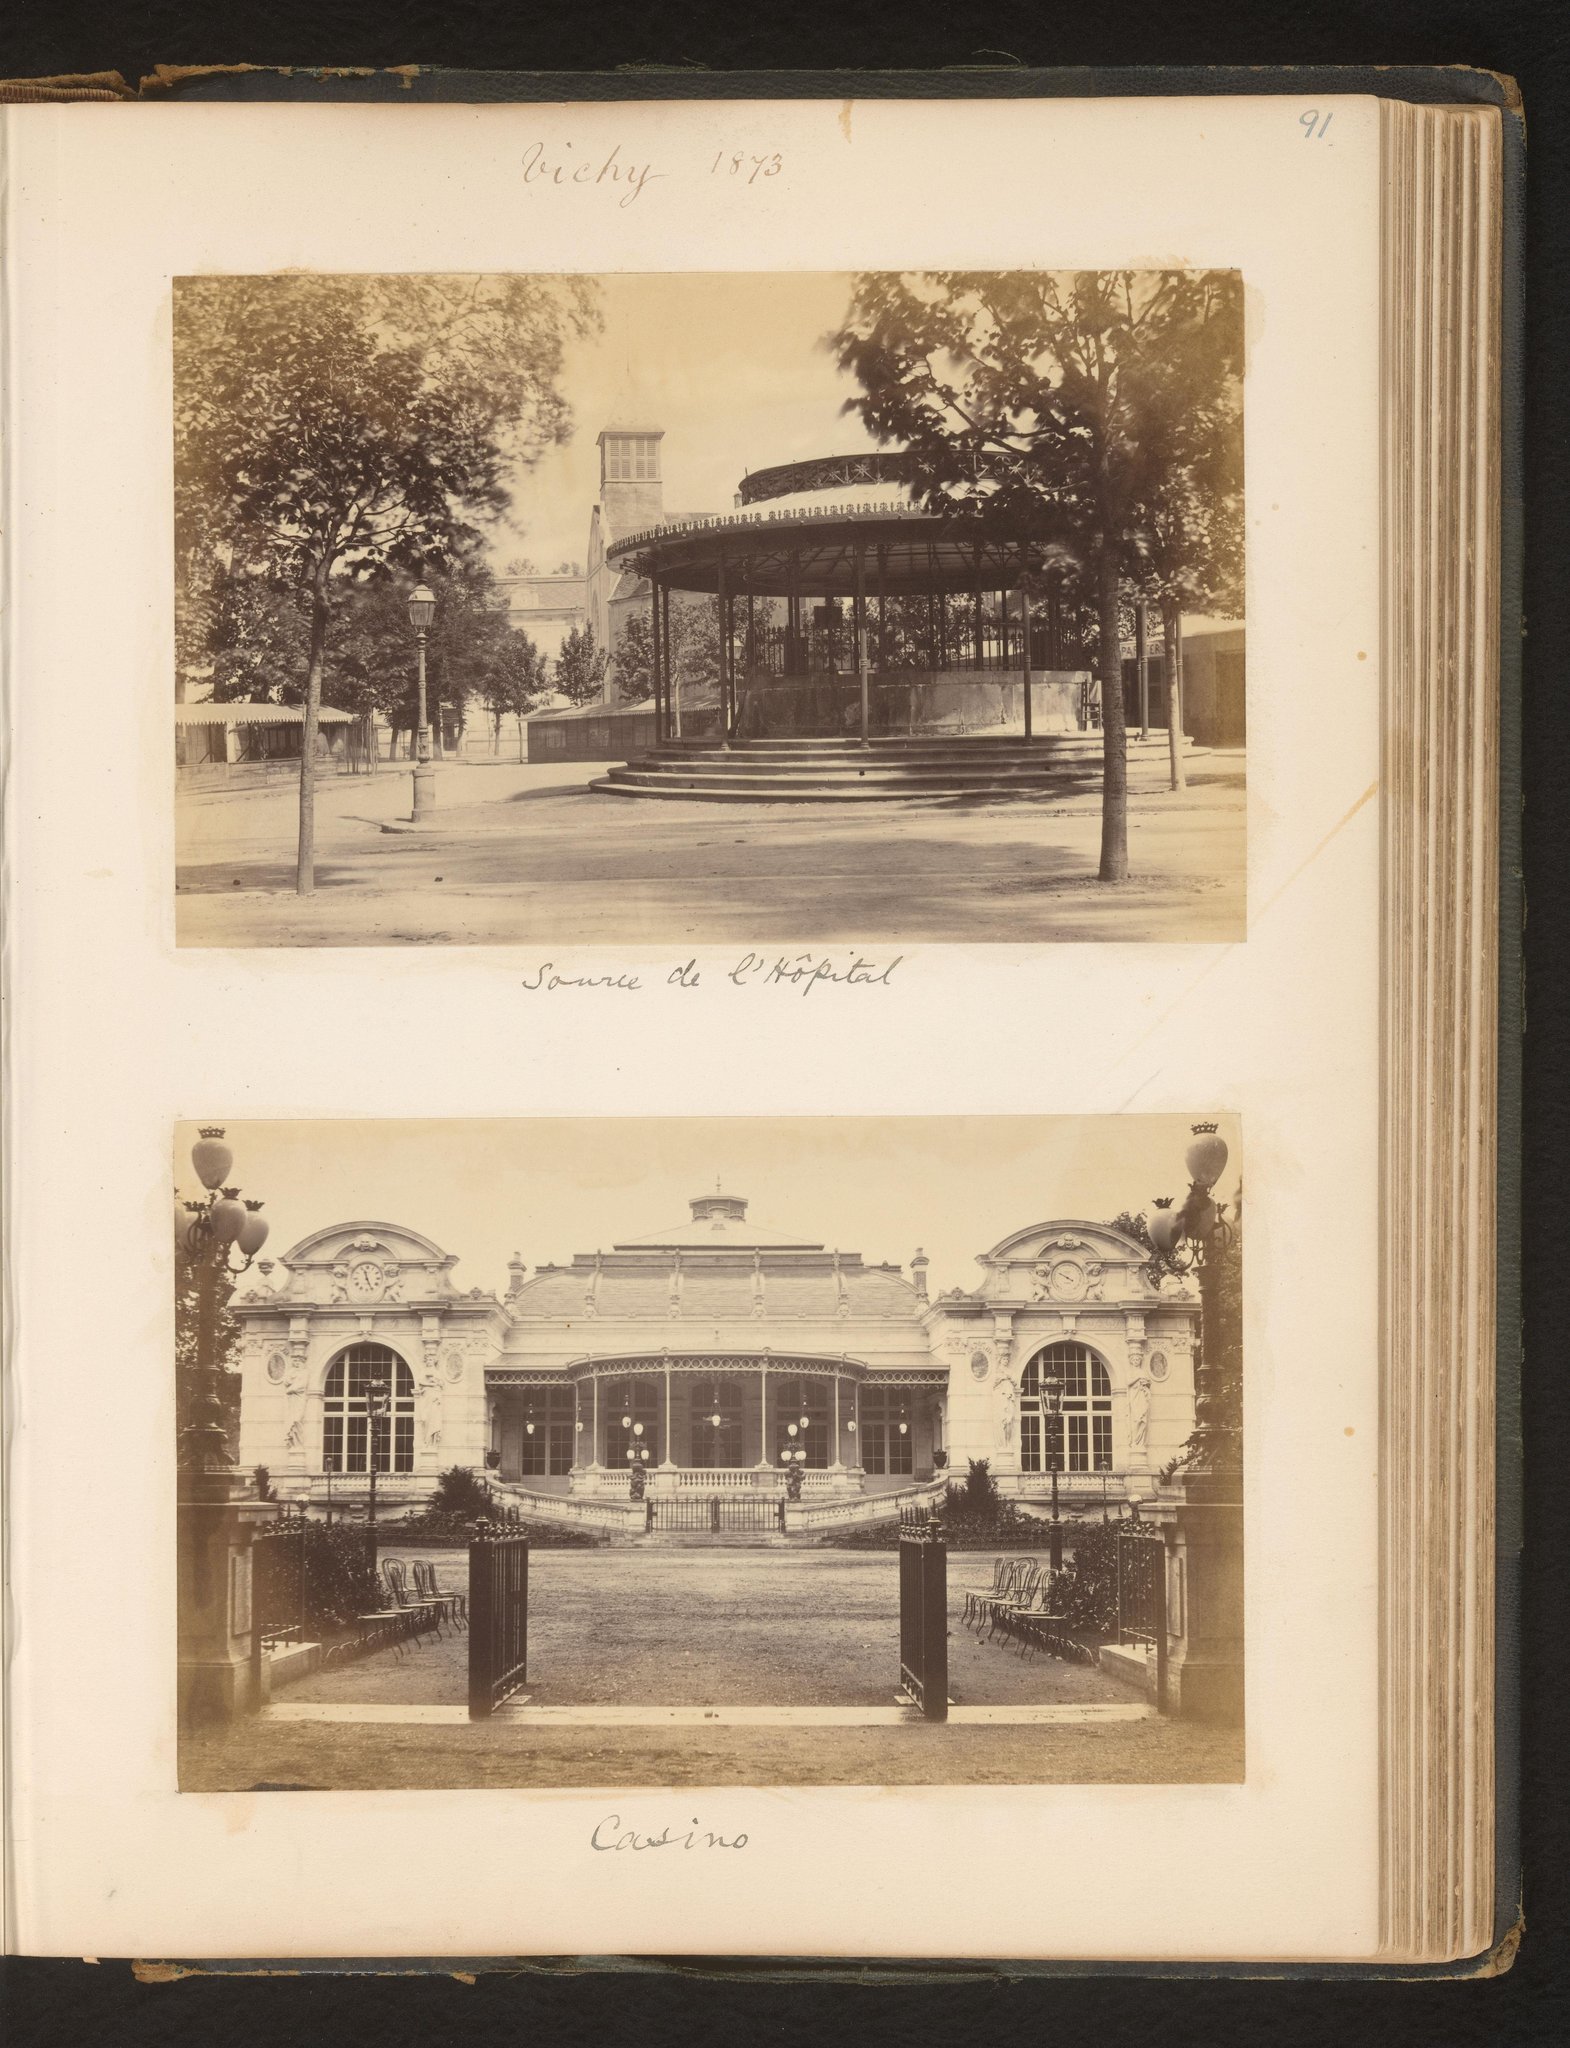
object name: album leaf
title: Gebouwen in Vichy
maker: Anonymous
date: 1873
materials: paper, photographic support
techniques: albumen print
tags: medicinal spring, casino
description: Waterbron source de l'hôpital en het casino van Vichy. Deze pagina maakt deel uit van een album.